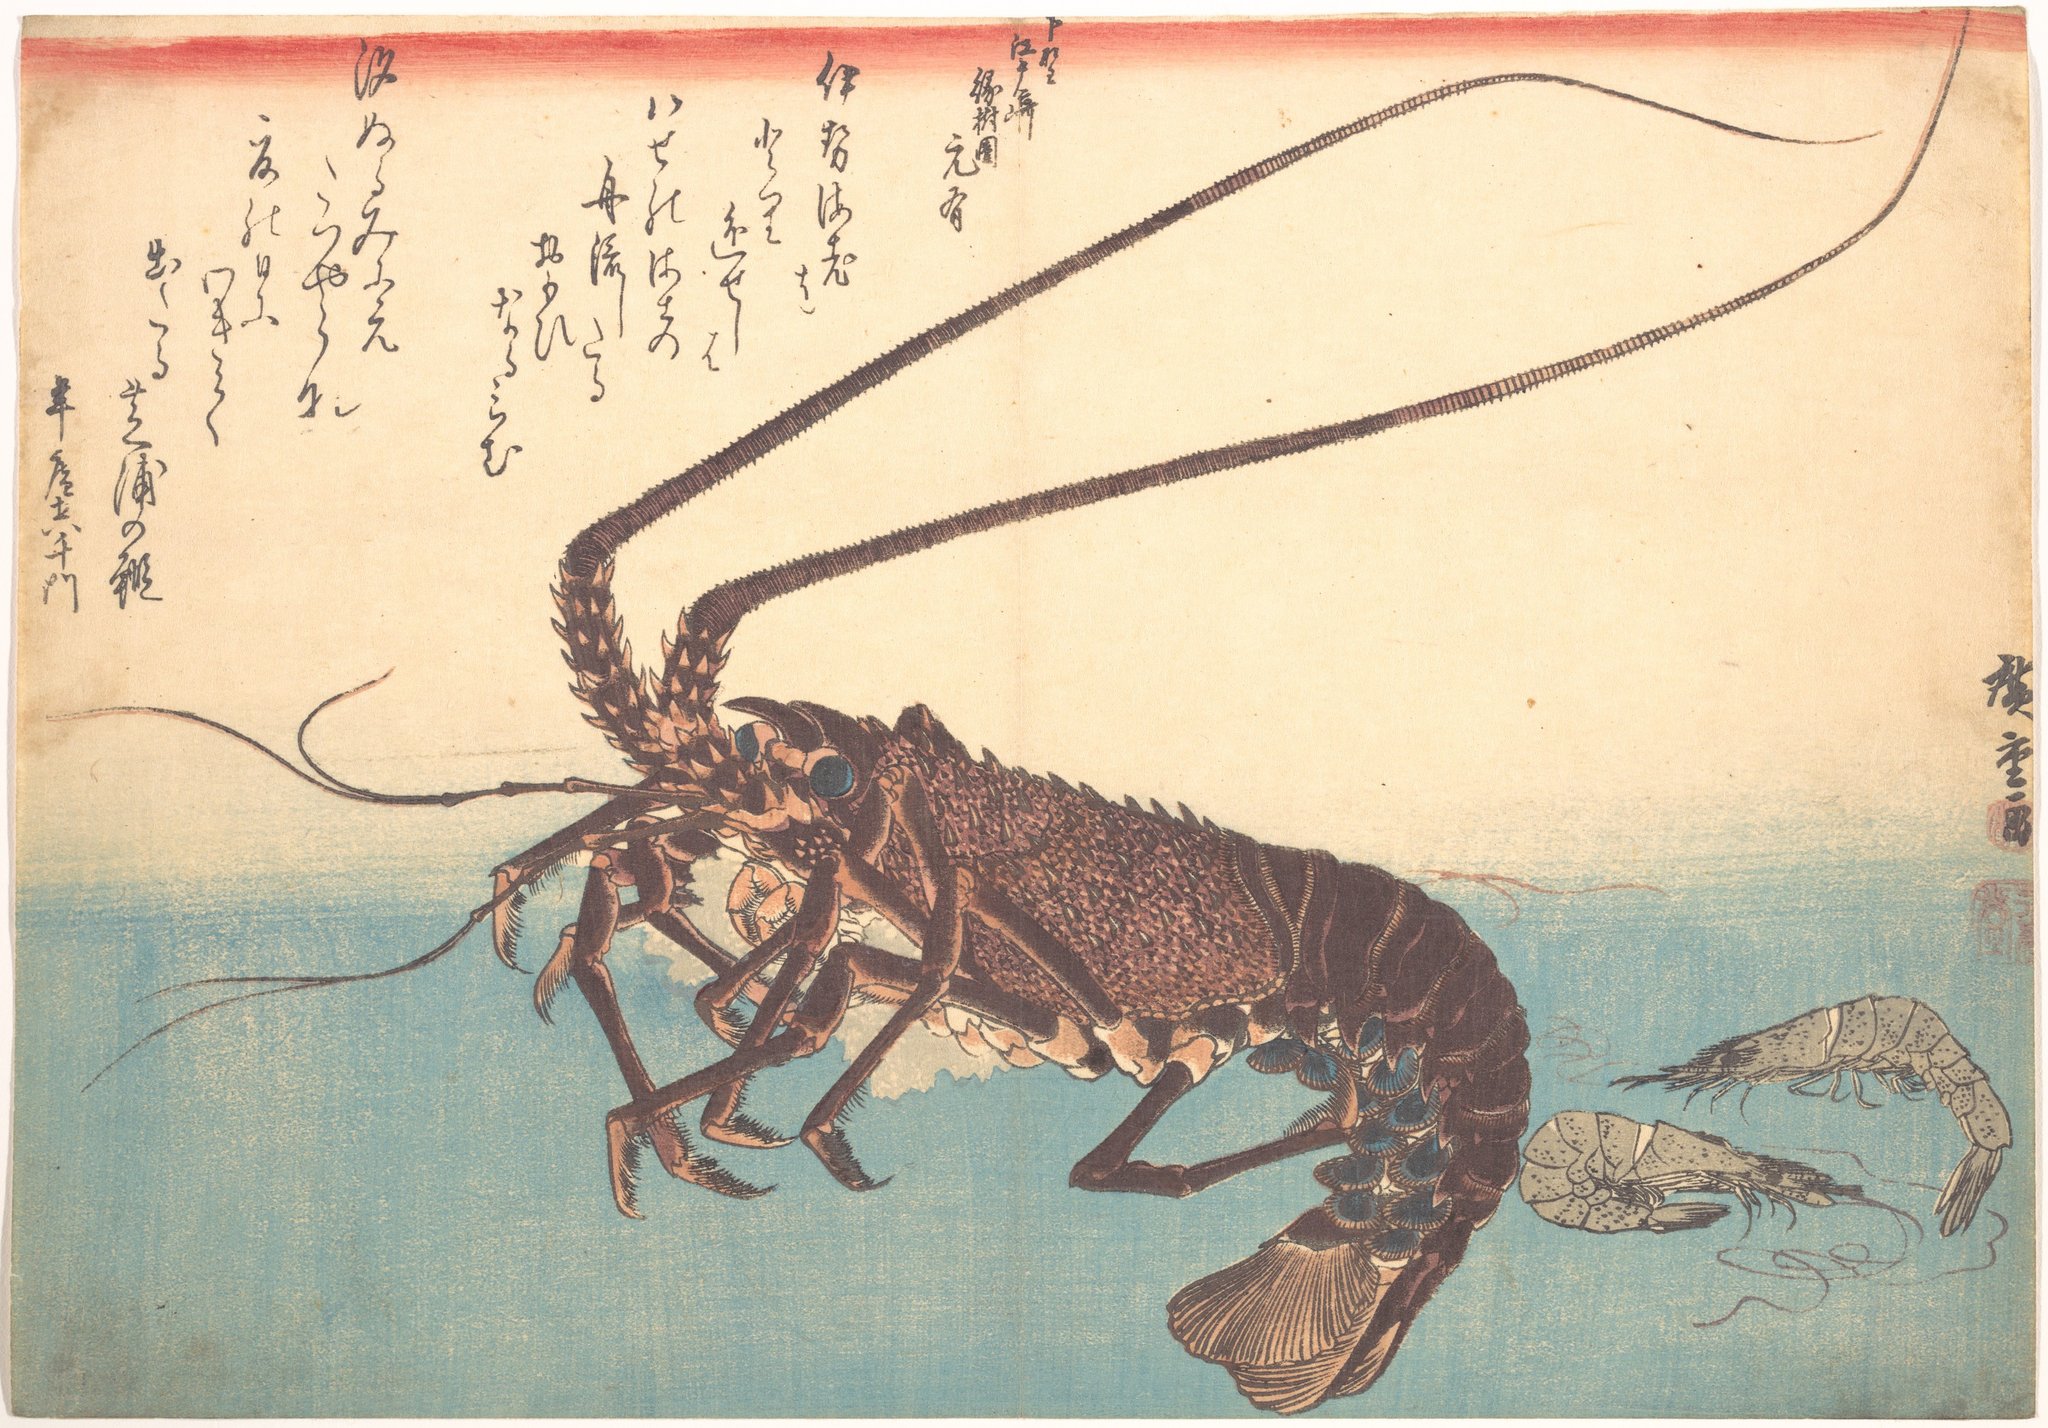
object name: woodblock print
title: Ise-ebi and Shiba-ebi, from the series Uozukushi (Every Variety of Fish)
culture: japanese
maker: utagawa hiroshige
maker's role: artist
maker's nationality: japanese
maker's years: 1797-1858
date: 1830-1839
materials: ink, paper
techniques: woodblock print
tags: lobsters